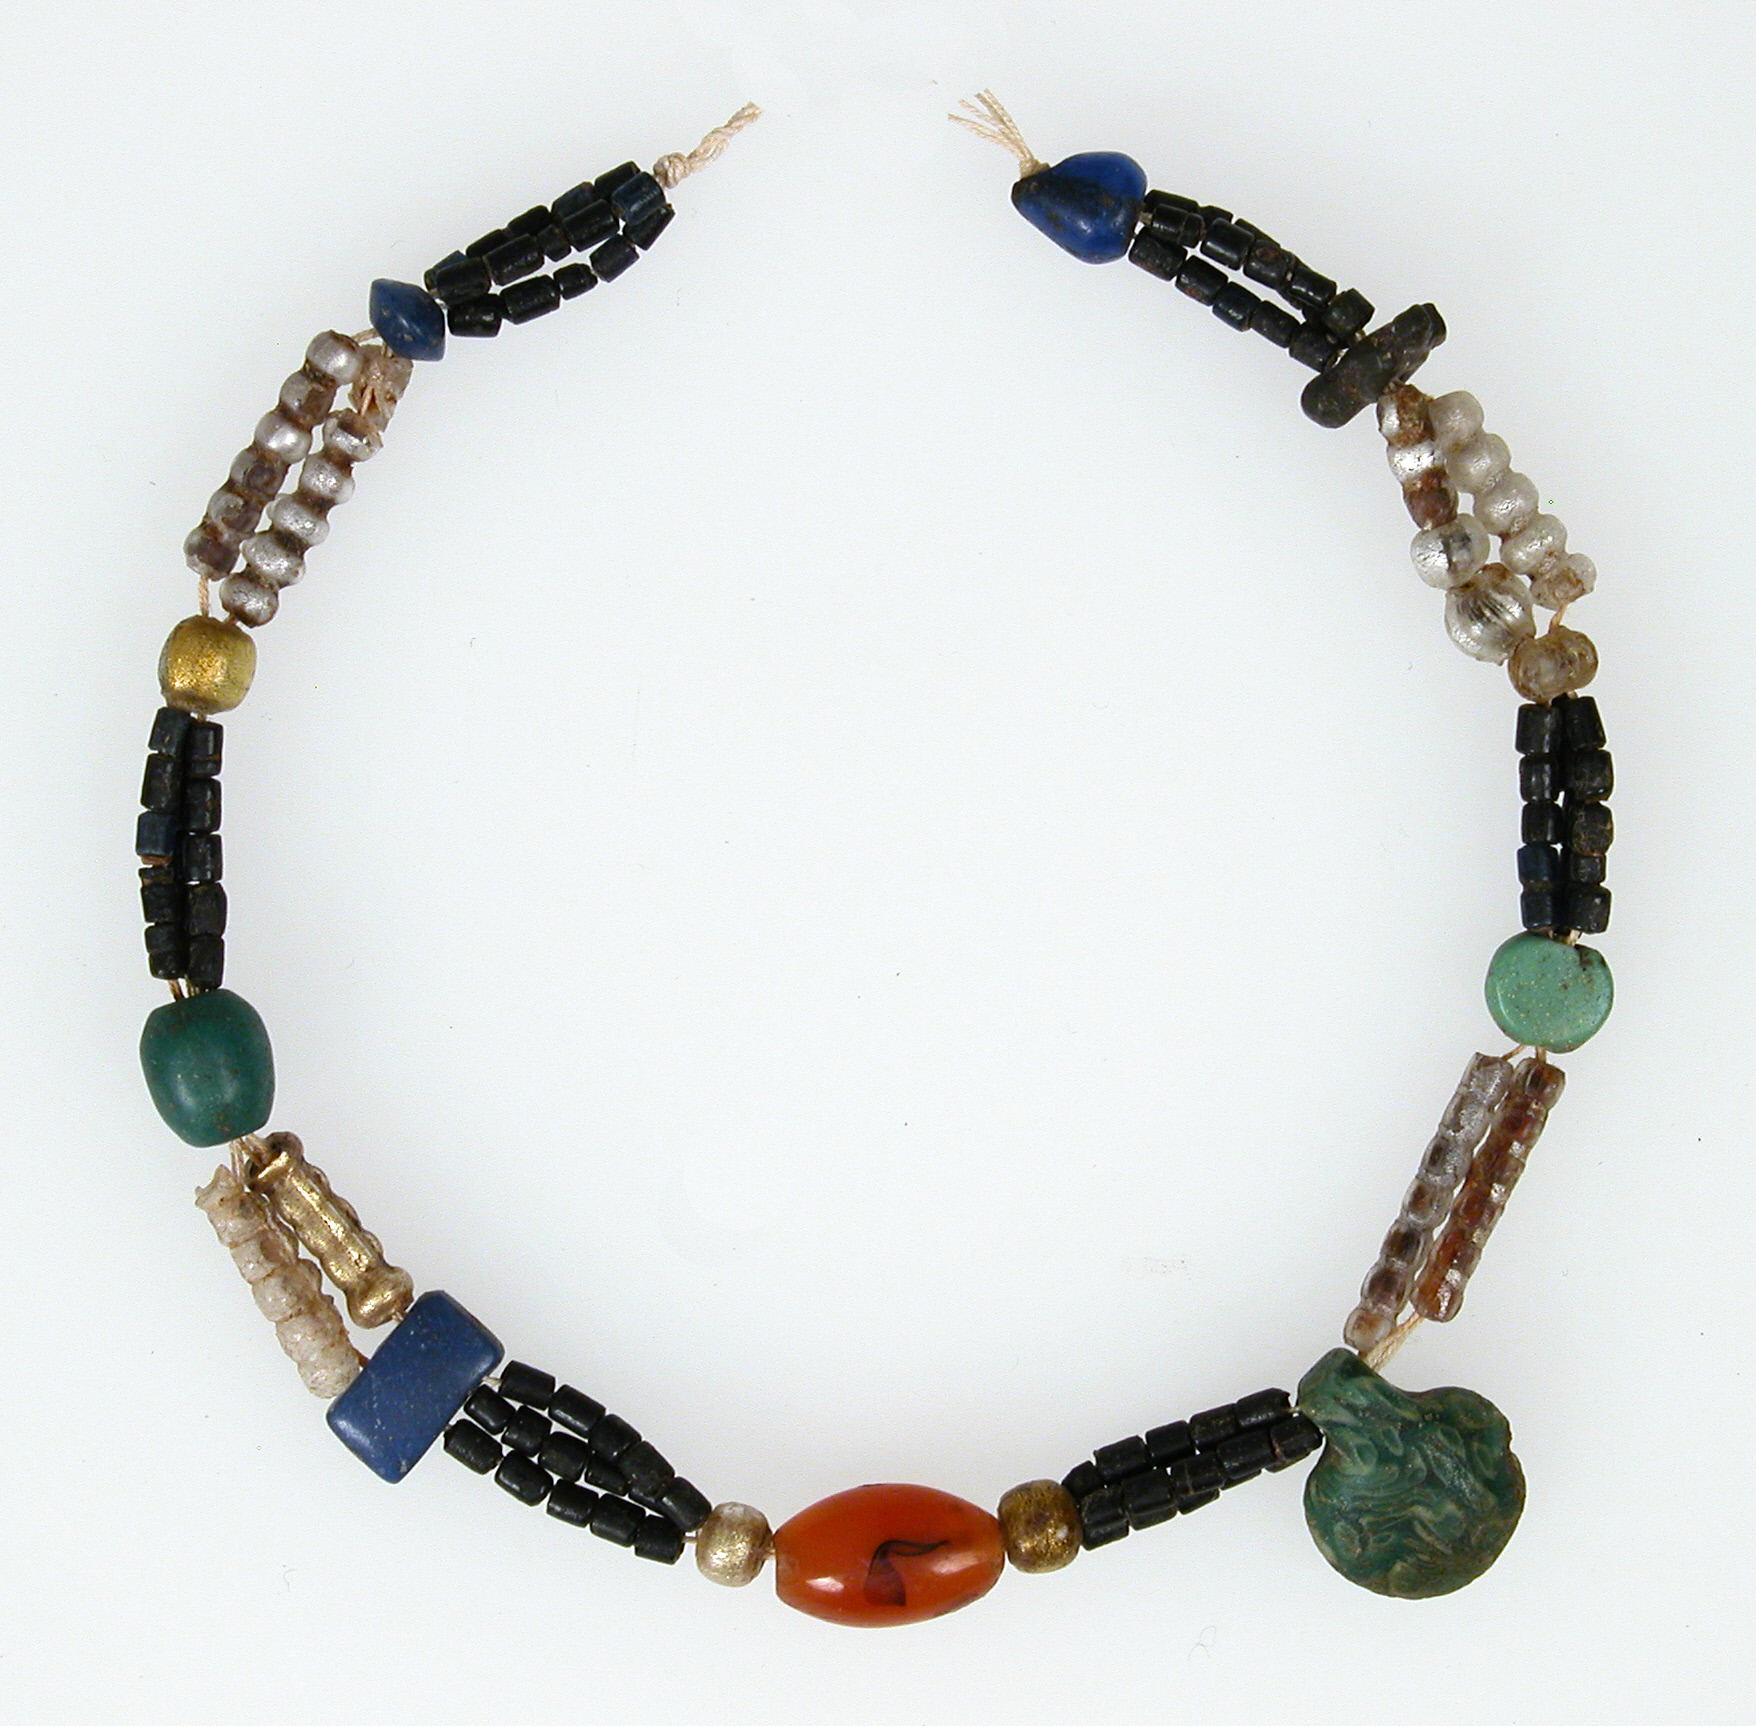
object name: bead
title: Double String of Beads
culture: coptic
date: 301-700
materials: glass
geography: egypt